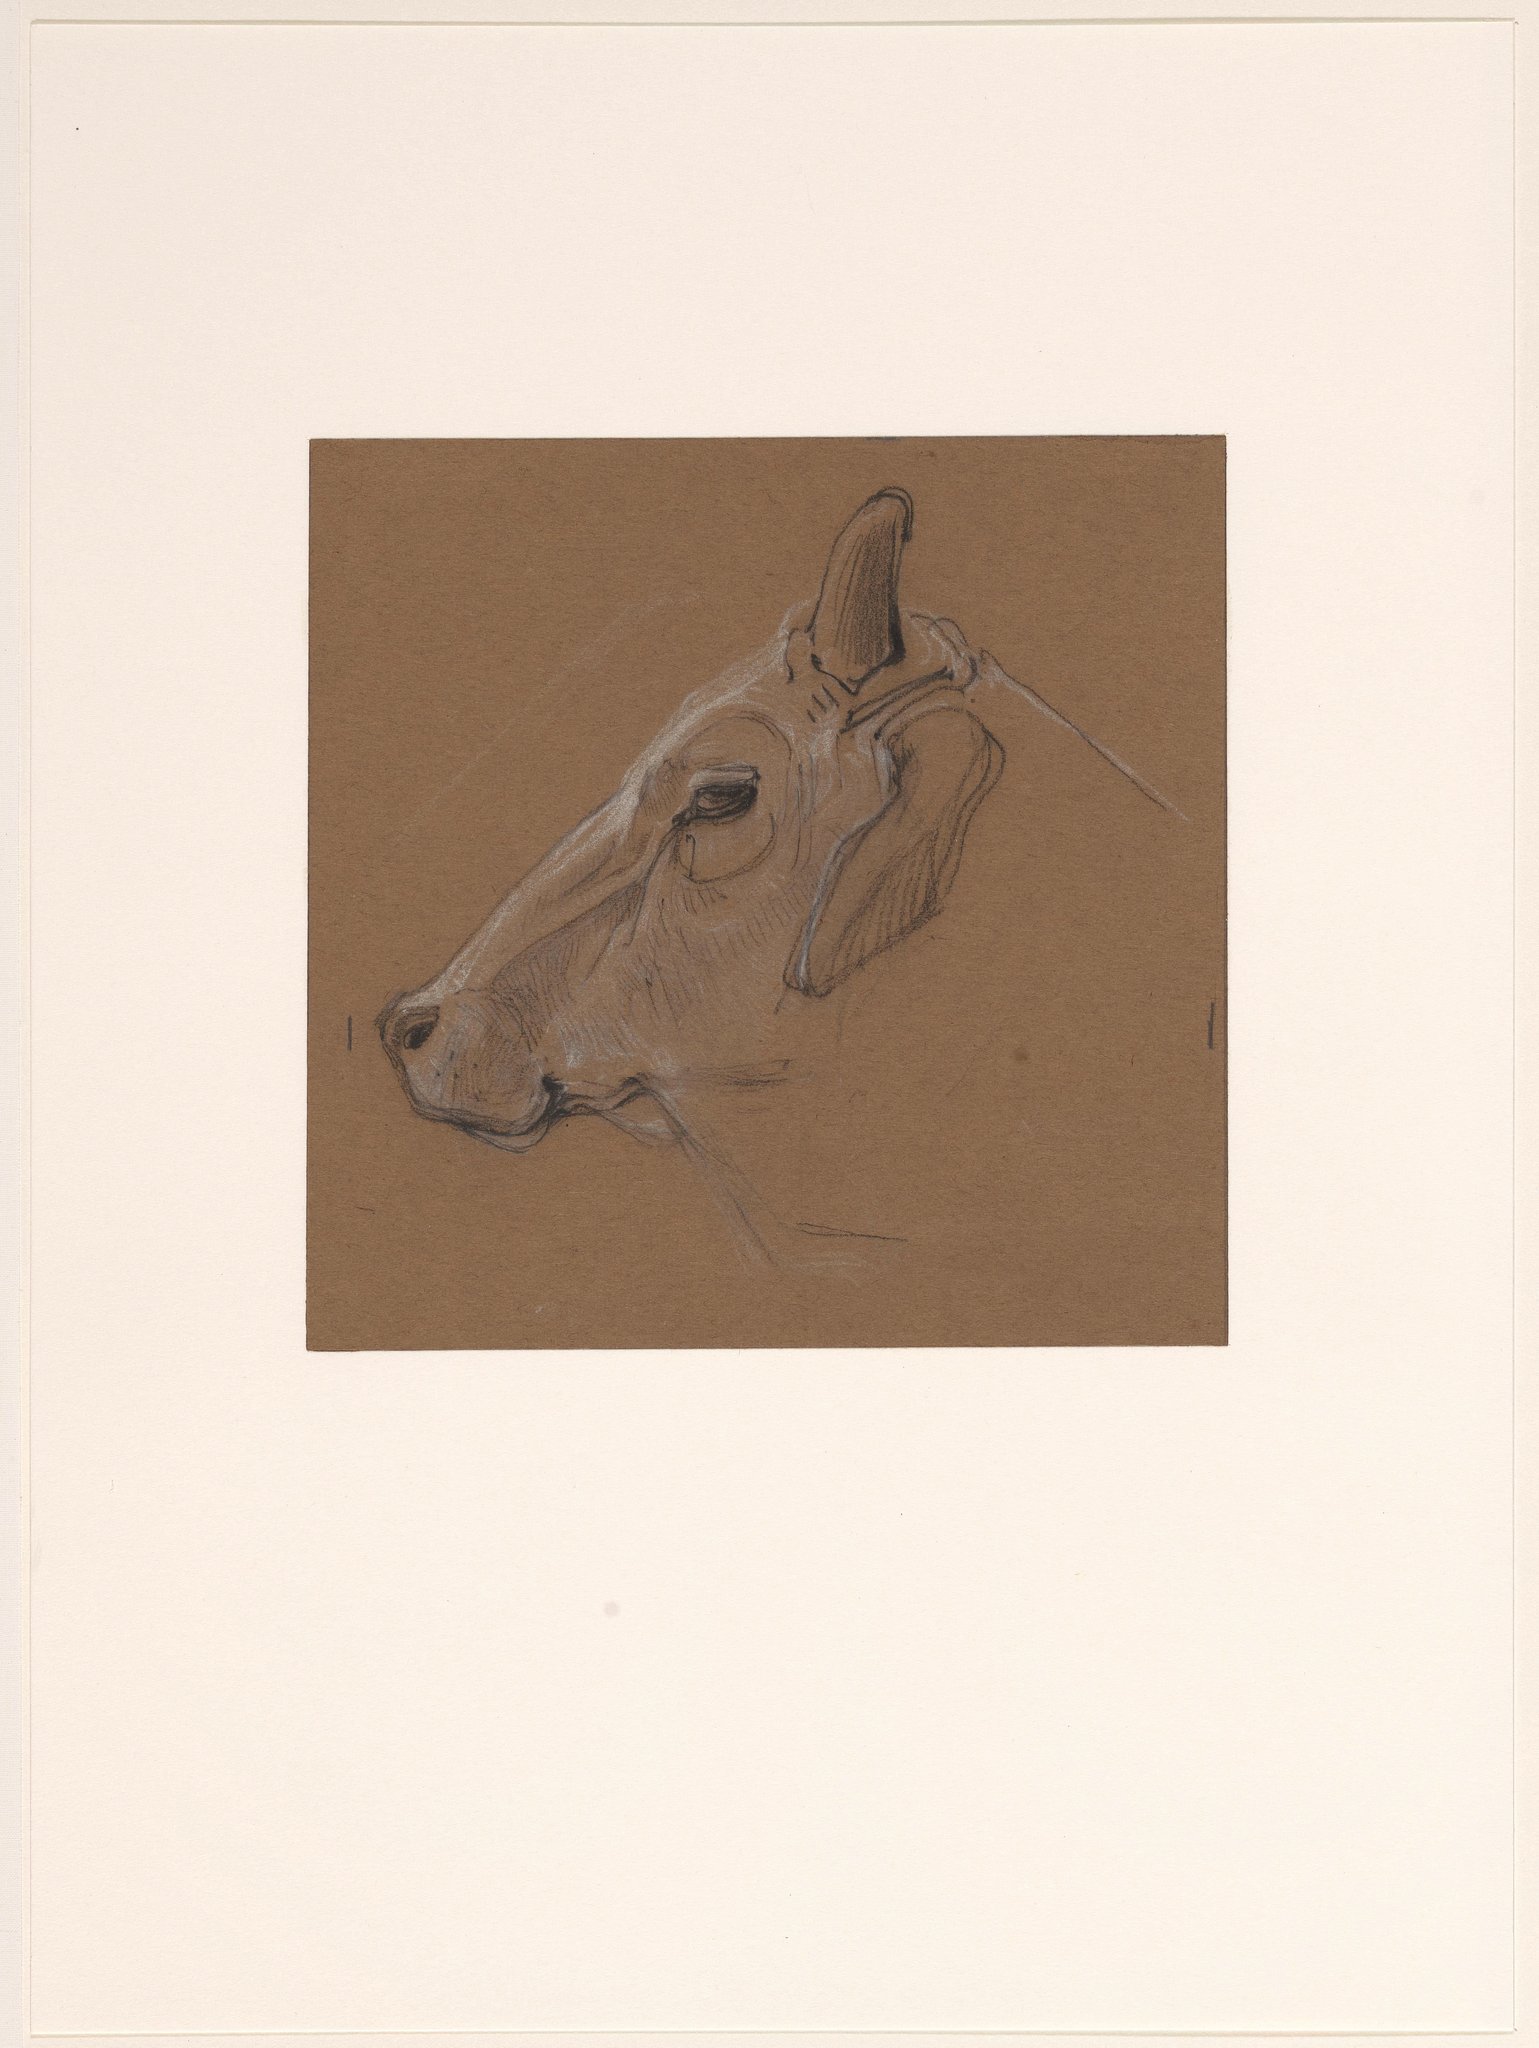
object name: drawing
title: Zebu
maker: bernard willem wierink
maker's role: draughtsman, print maker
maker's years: 1856-1939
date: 1866-1939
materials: chalk, paper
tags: hoofed animals: zebu (head of an animal)